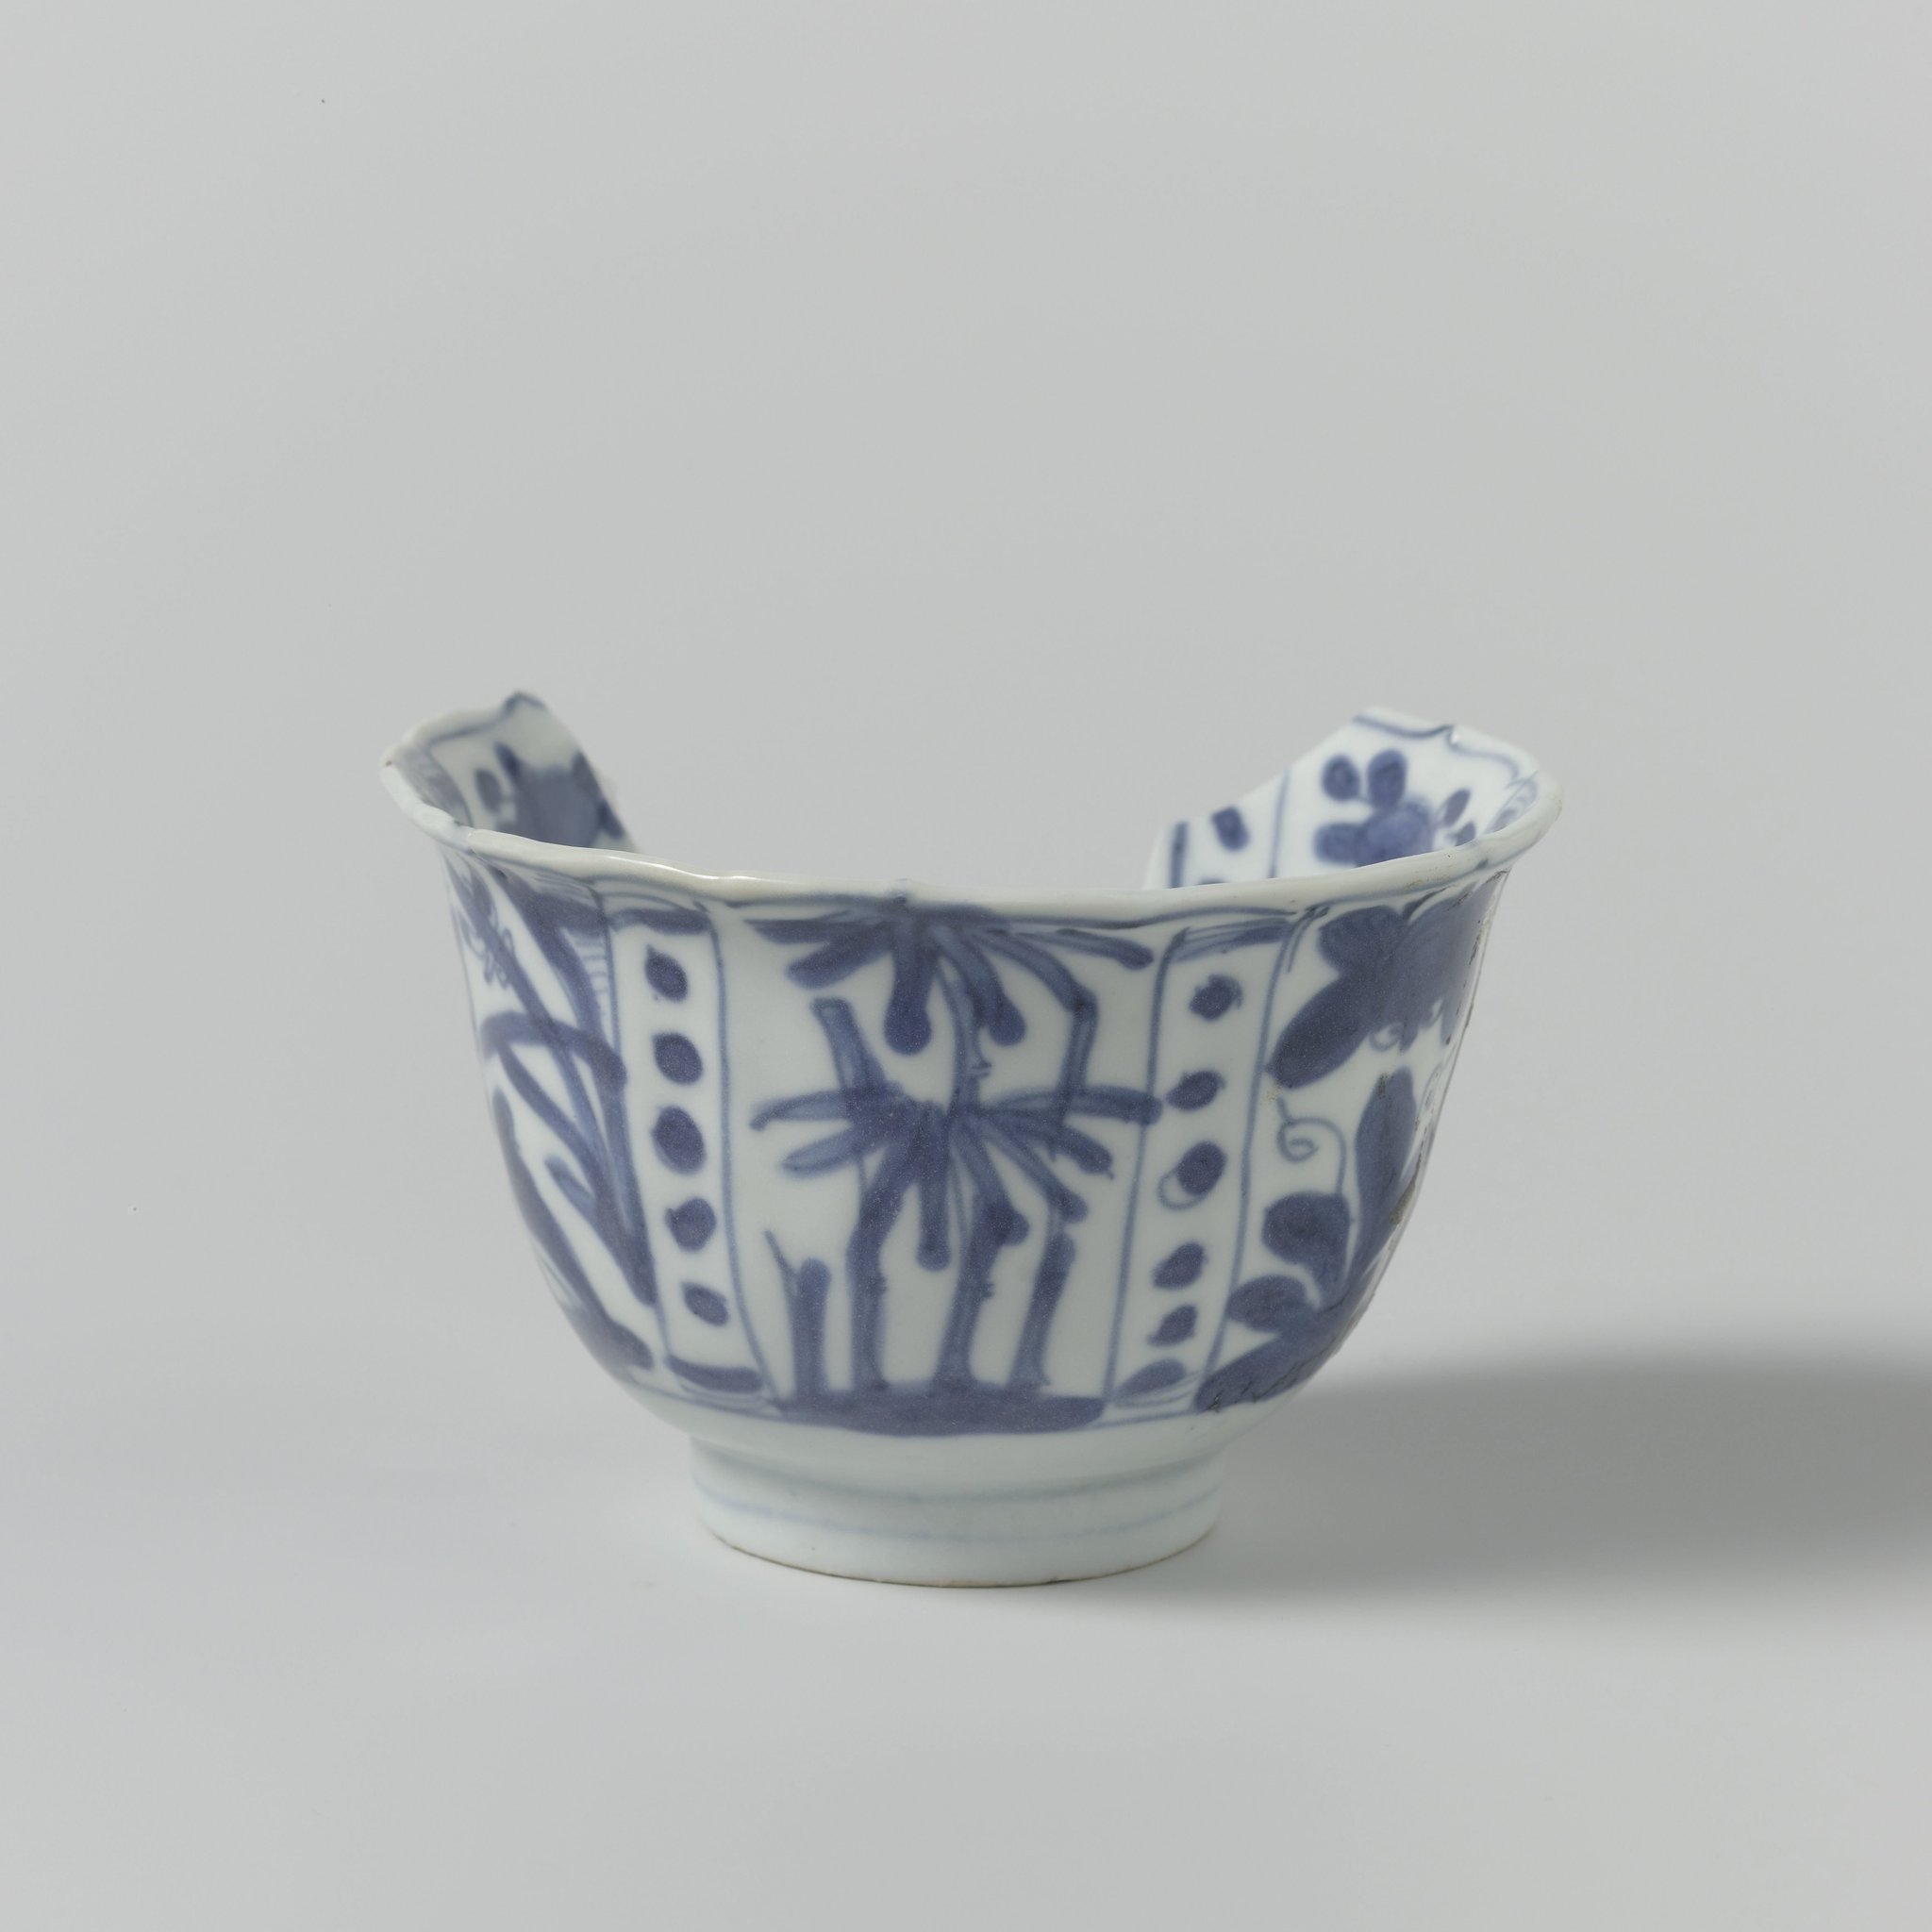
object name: bowl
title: High bowl of Chinese porcelain from the wreck of the Dutch East Indiaman Witte Leeuw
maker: Anonymous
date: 1613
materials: bone china, gypsum, porcelain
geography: jingdezhen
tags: verenigde oostindische compagnie, sint-helena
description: Fragment kom uit V.O.C.-schip de 'Witte Leeuw', 90% aanwezig: een deel van de rand ontbreekt. De kom is opgebouwd uit scherven en hersteld met gips. De scherf is glasachtig wit en kent nauwelijks ingebakken vuil. Het glazuur is blauwgetint. De bodem is geglazuurd, kent schuins-radiale ribbels en de voetring staat naar binnen en is gefacetteerd. Er is weinig ovenzand aangetroffen.